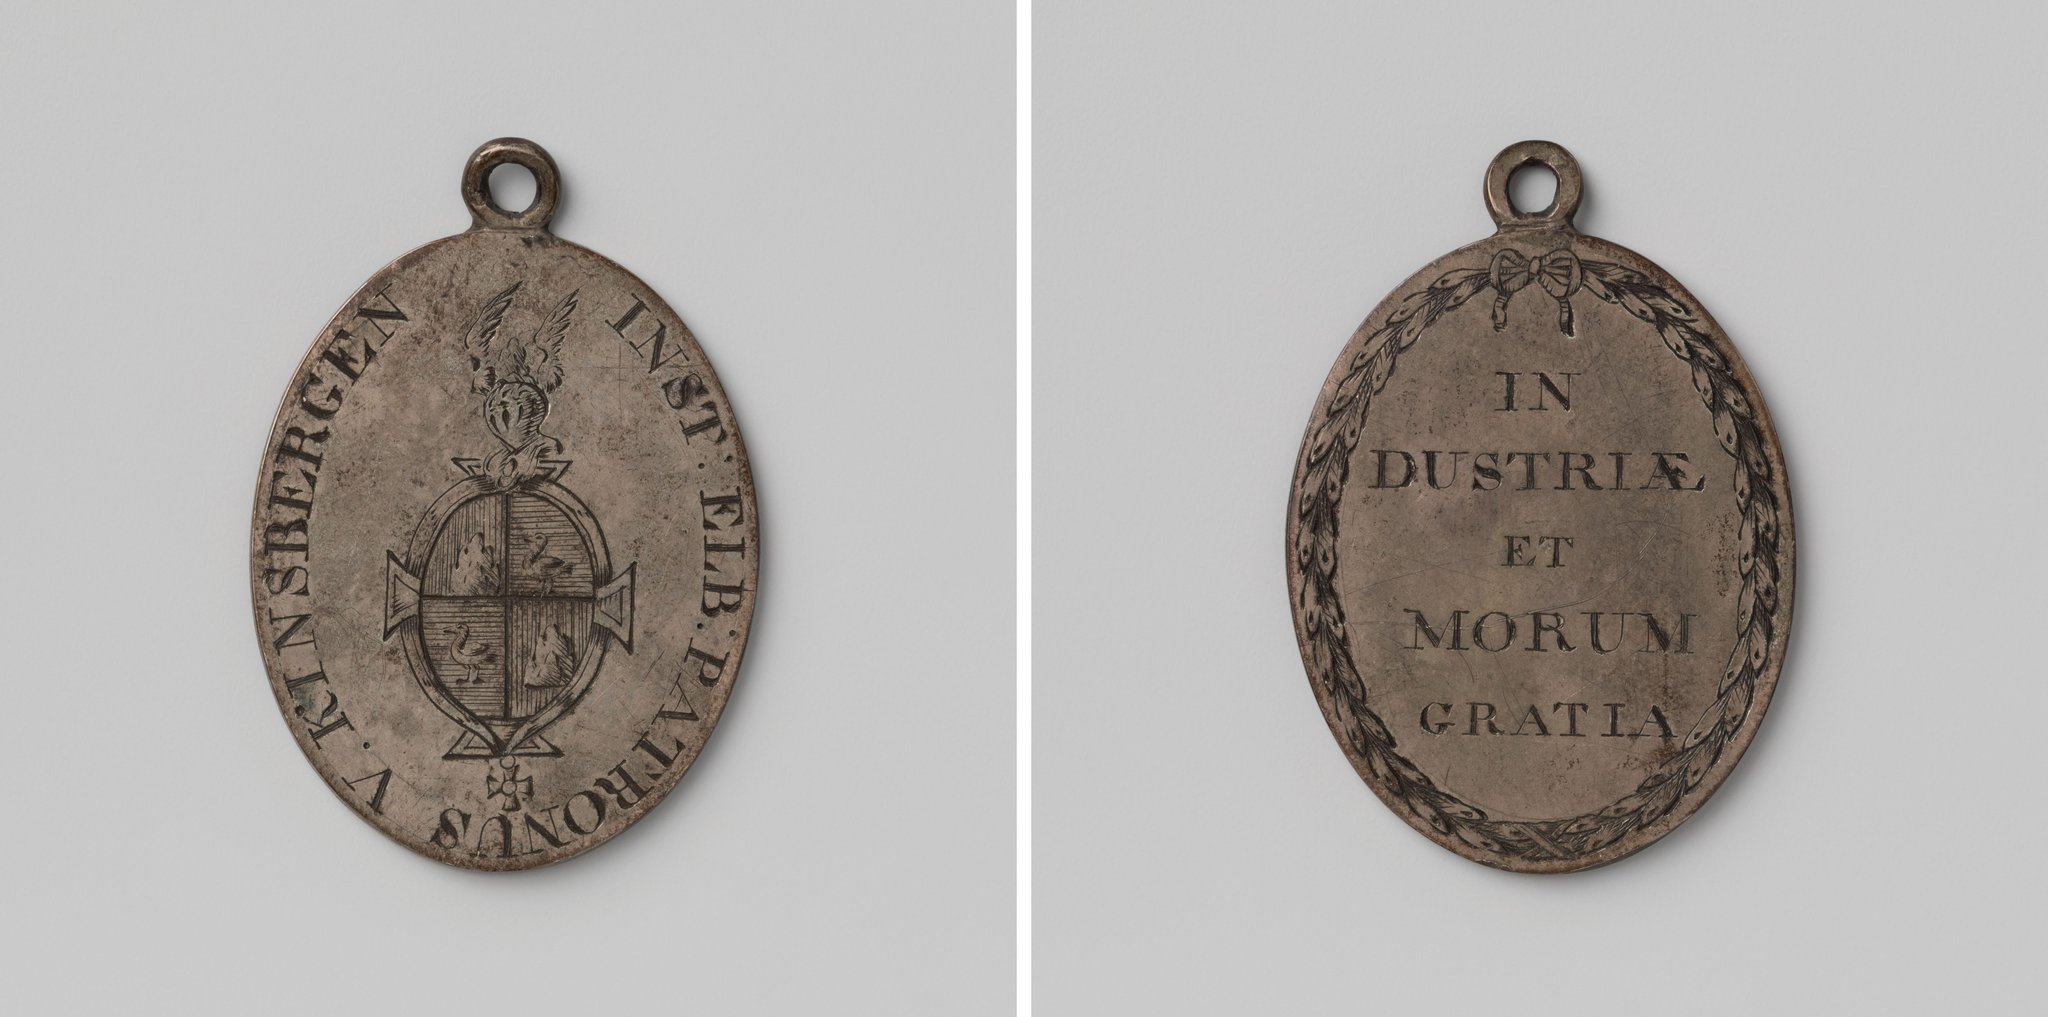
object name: medal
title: Instituut van Kinsbergen te Elburg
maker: Anonymous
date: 1806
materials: silver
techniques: engraving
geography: netherlands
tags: jonkheer jan hendrik van kinsbergen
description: Zilveren ovale penning met draagoog. Voorzijde: gehelmd wapenschild omhangen met de orde van H. Anna en Alexander Newsy binnen omschrift. Keerzijde: opschrift binnen lauwerkrans.